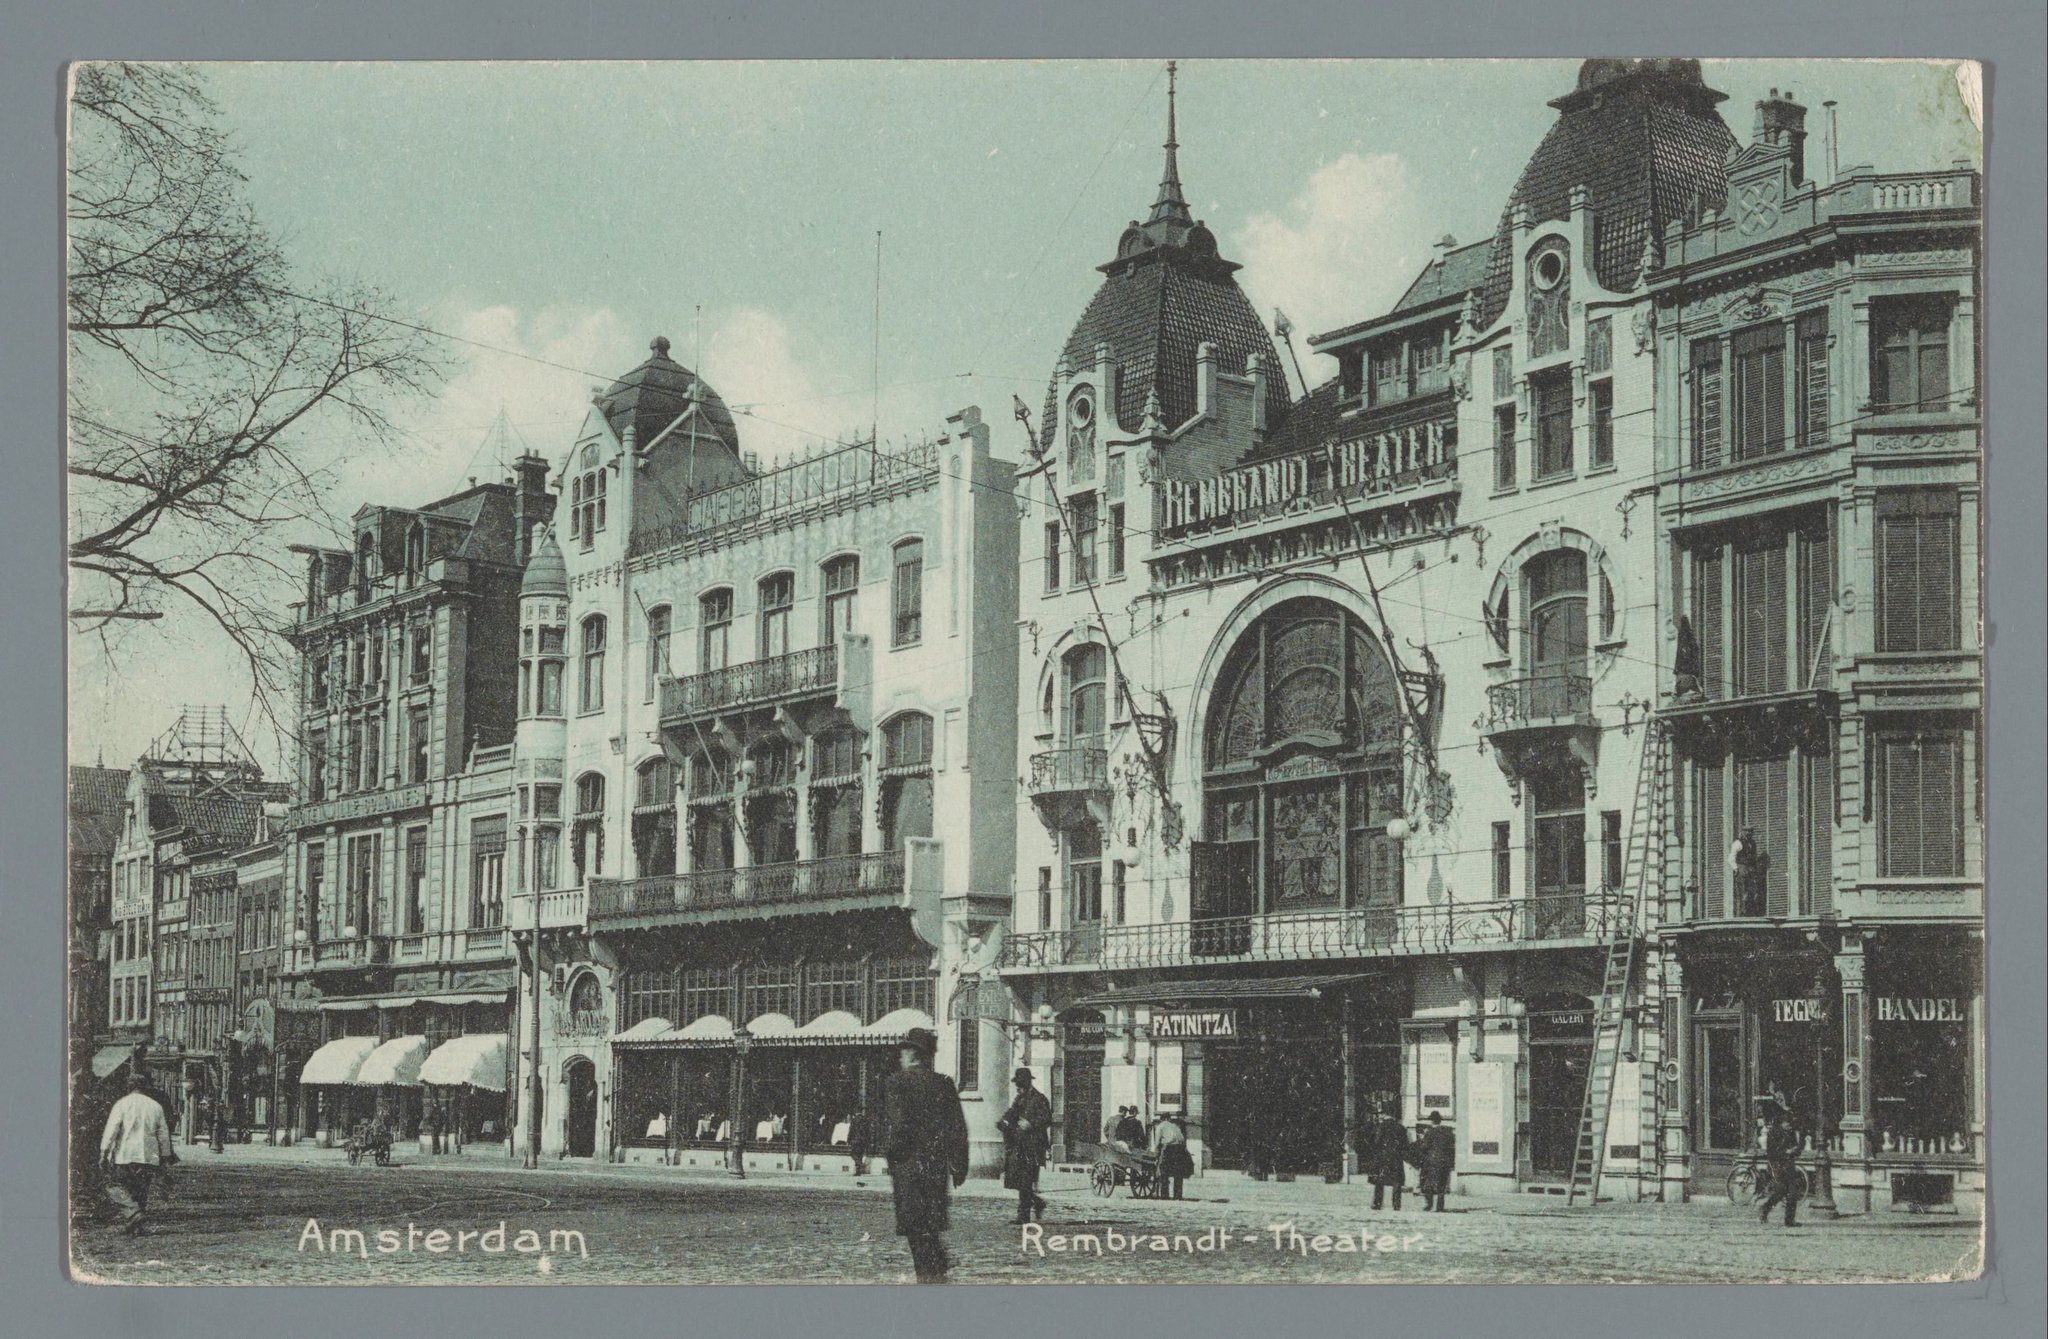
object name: ansichtkaart, prentbriefkaart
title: Amsterdam, Rembrandt-Theater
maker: a.j. nuss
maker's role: printer, publisher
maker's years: 1843-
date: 1875-1930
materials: cardboard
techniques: photograph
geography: amsterdam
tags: theatre (building)